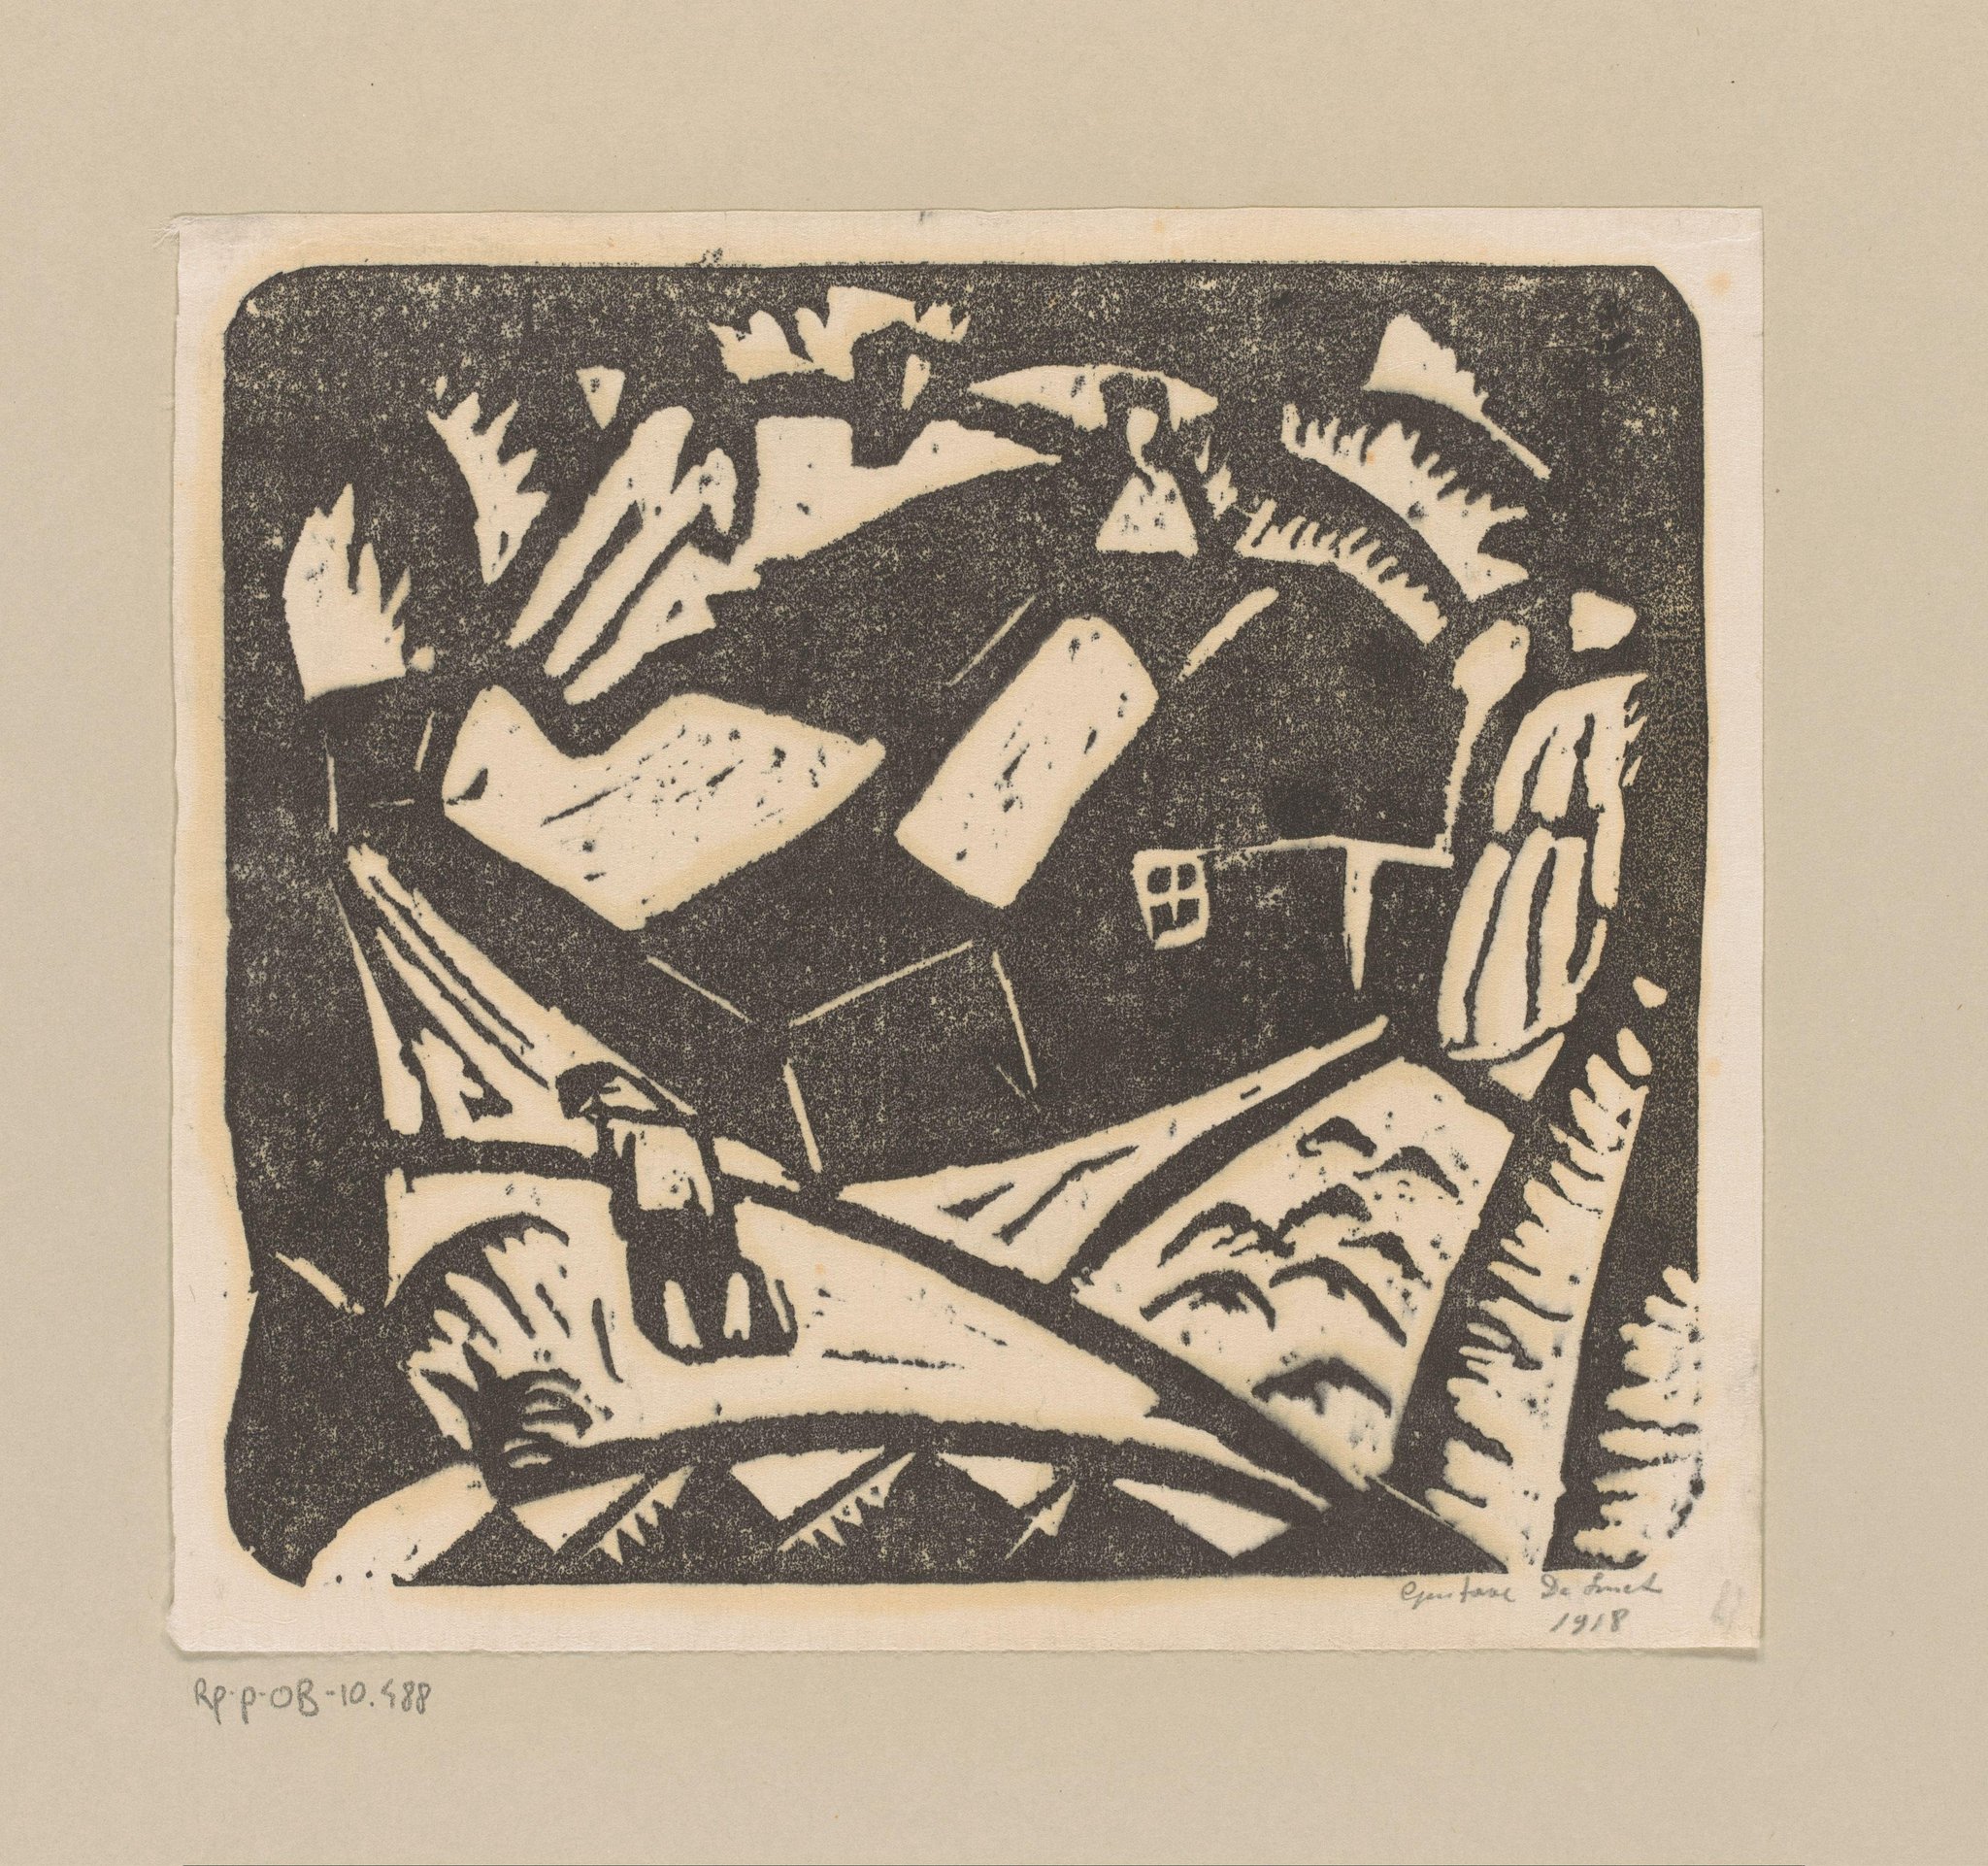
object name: print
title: Boerderij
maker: gustave de smet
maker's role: print maker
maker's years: 1877-1943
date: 1918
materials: paper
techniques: woodcut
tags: farm or solitary house in landscape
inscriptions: date